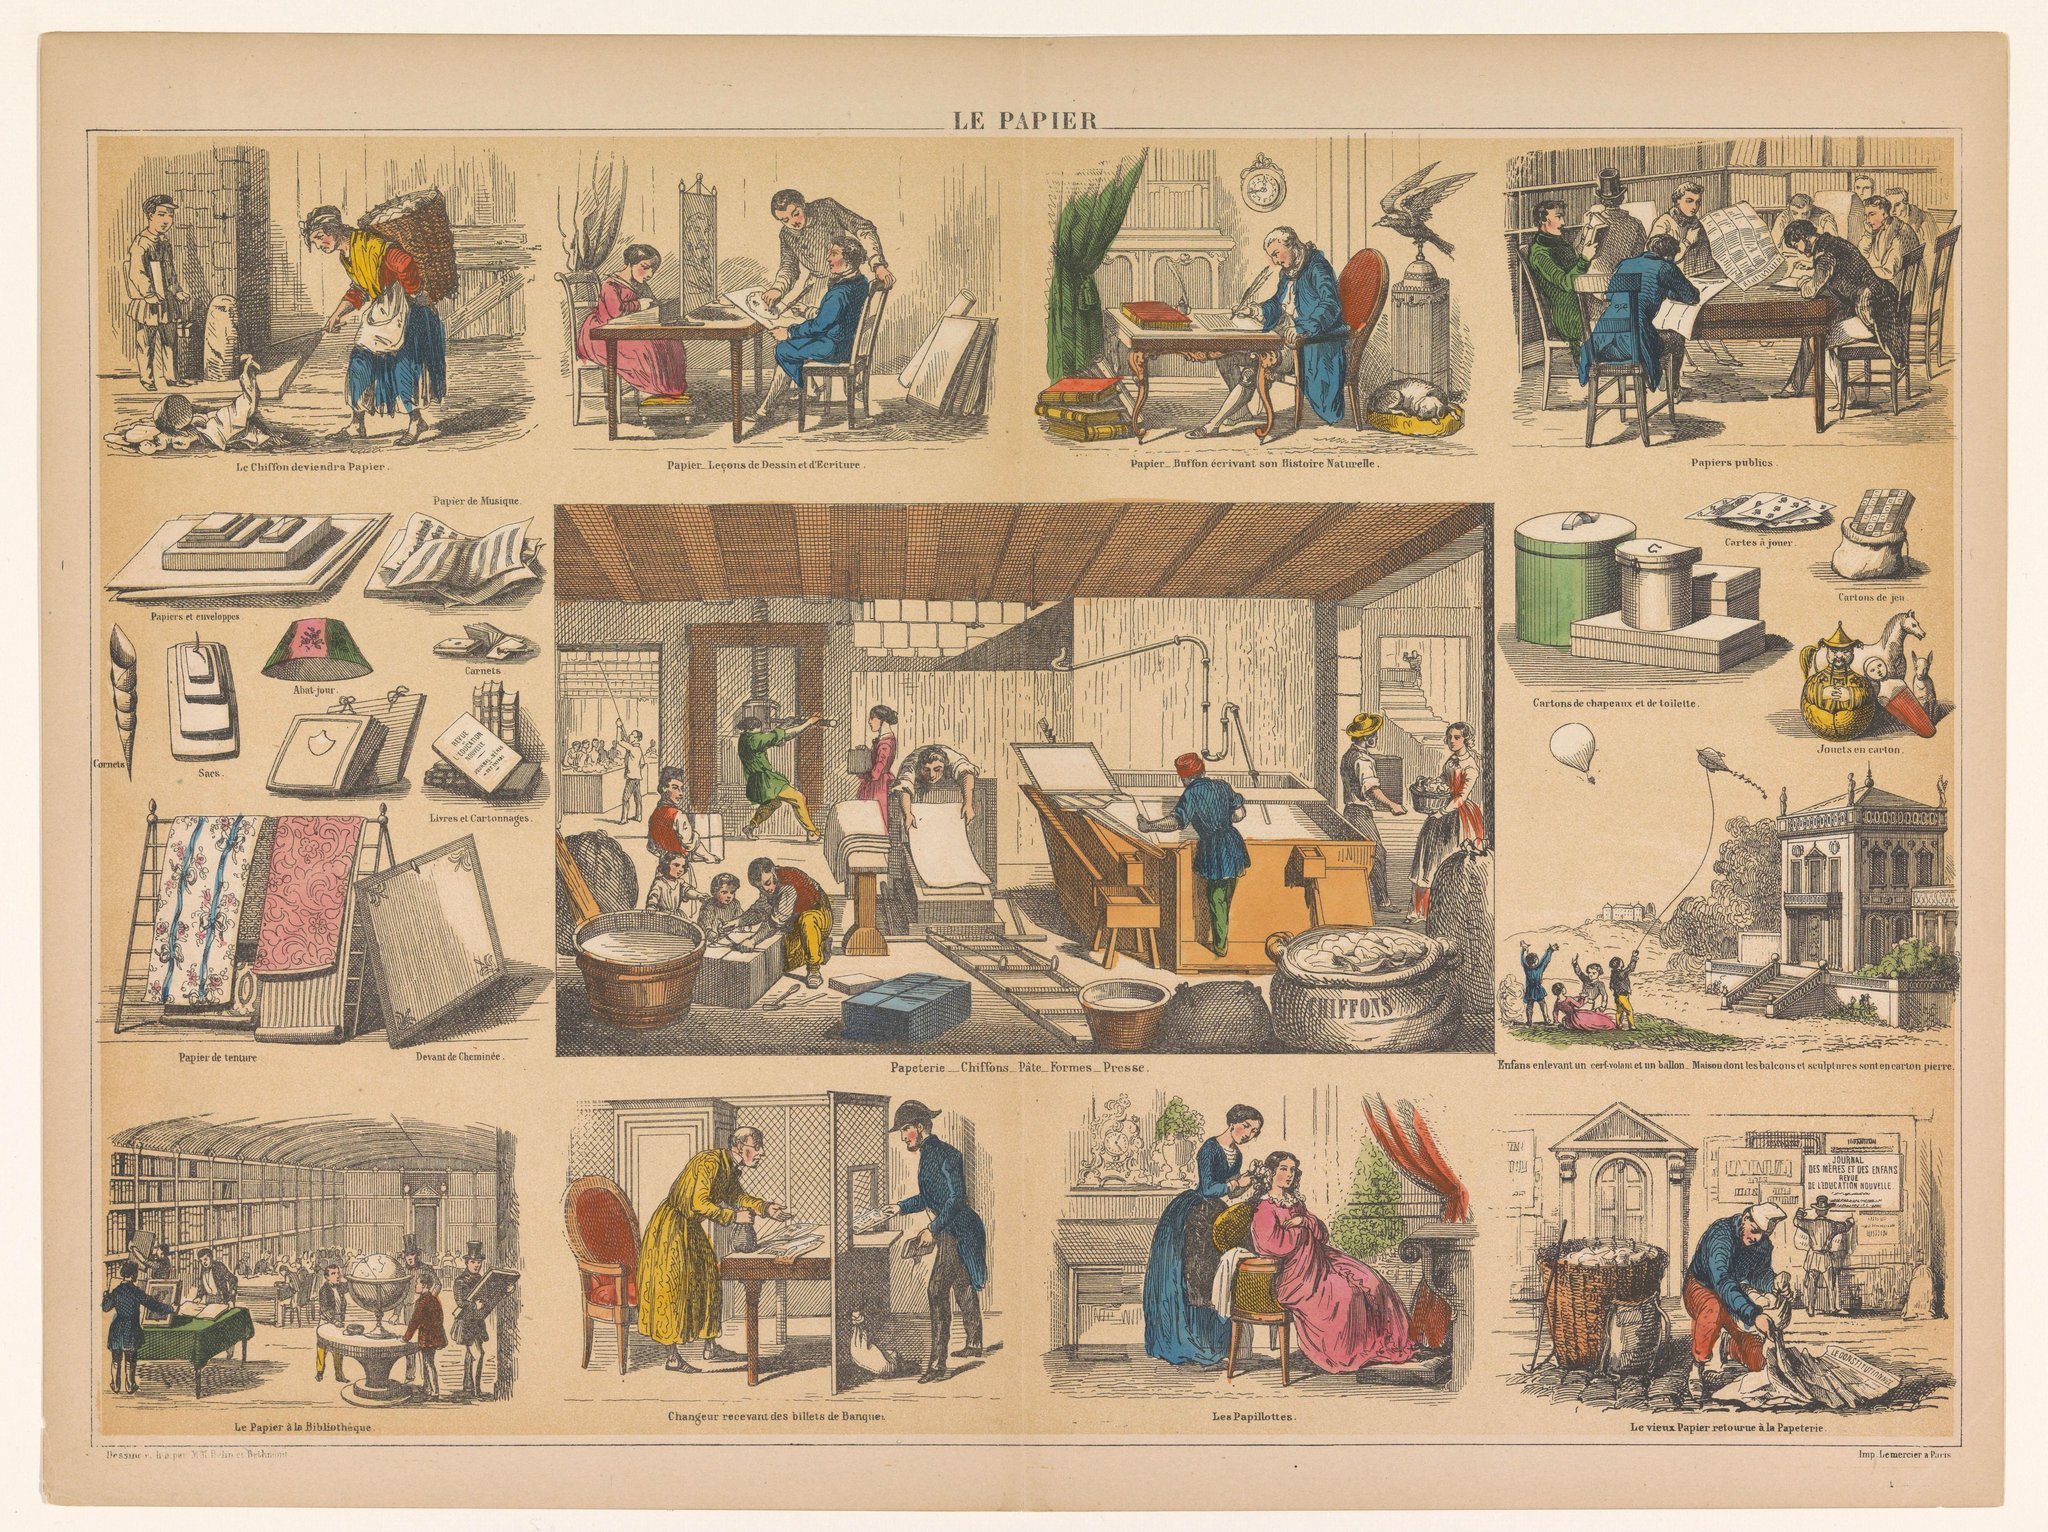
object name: print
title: Productie en gebruik van papier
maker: joseph rose lemercier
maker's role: printer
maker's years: 1803-1887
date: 1850-1875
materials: paper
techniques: hand coloring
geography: paris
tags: paris, georges-louis leclerc de buffon (graaf), handwriting, writing as activity, handicrafts, craftsman at work, reading, money-changer, paper (writing material), public library, garbage collection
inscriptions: collector's mark: Lugt 4779, collector's mark: Lugt 2228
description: Blad met in het midden het interieur van een papiermakerij. Daarboven een voddenraapster, een tekenles, Buffon achter zijn schrijftafel en lezende mannen in een bibliotheek. Daaronder een bibliotheek, een geldwisselaar, een vrouw met papillotten in haar haar en een verzamelaar van oud papier. Links en rechts van de centrale scène producten die uit papier vervaardigd zijn.